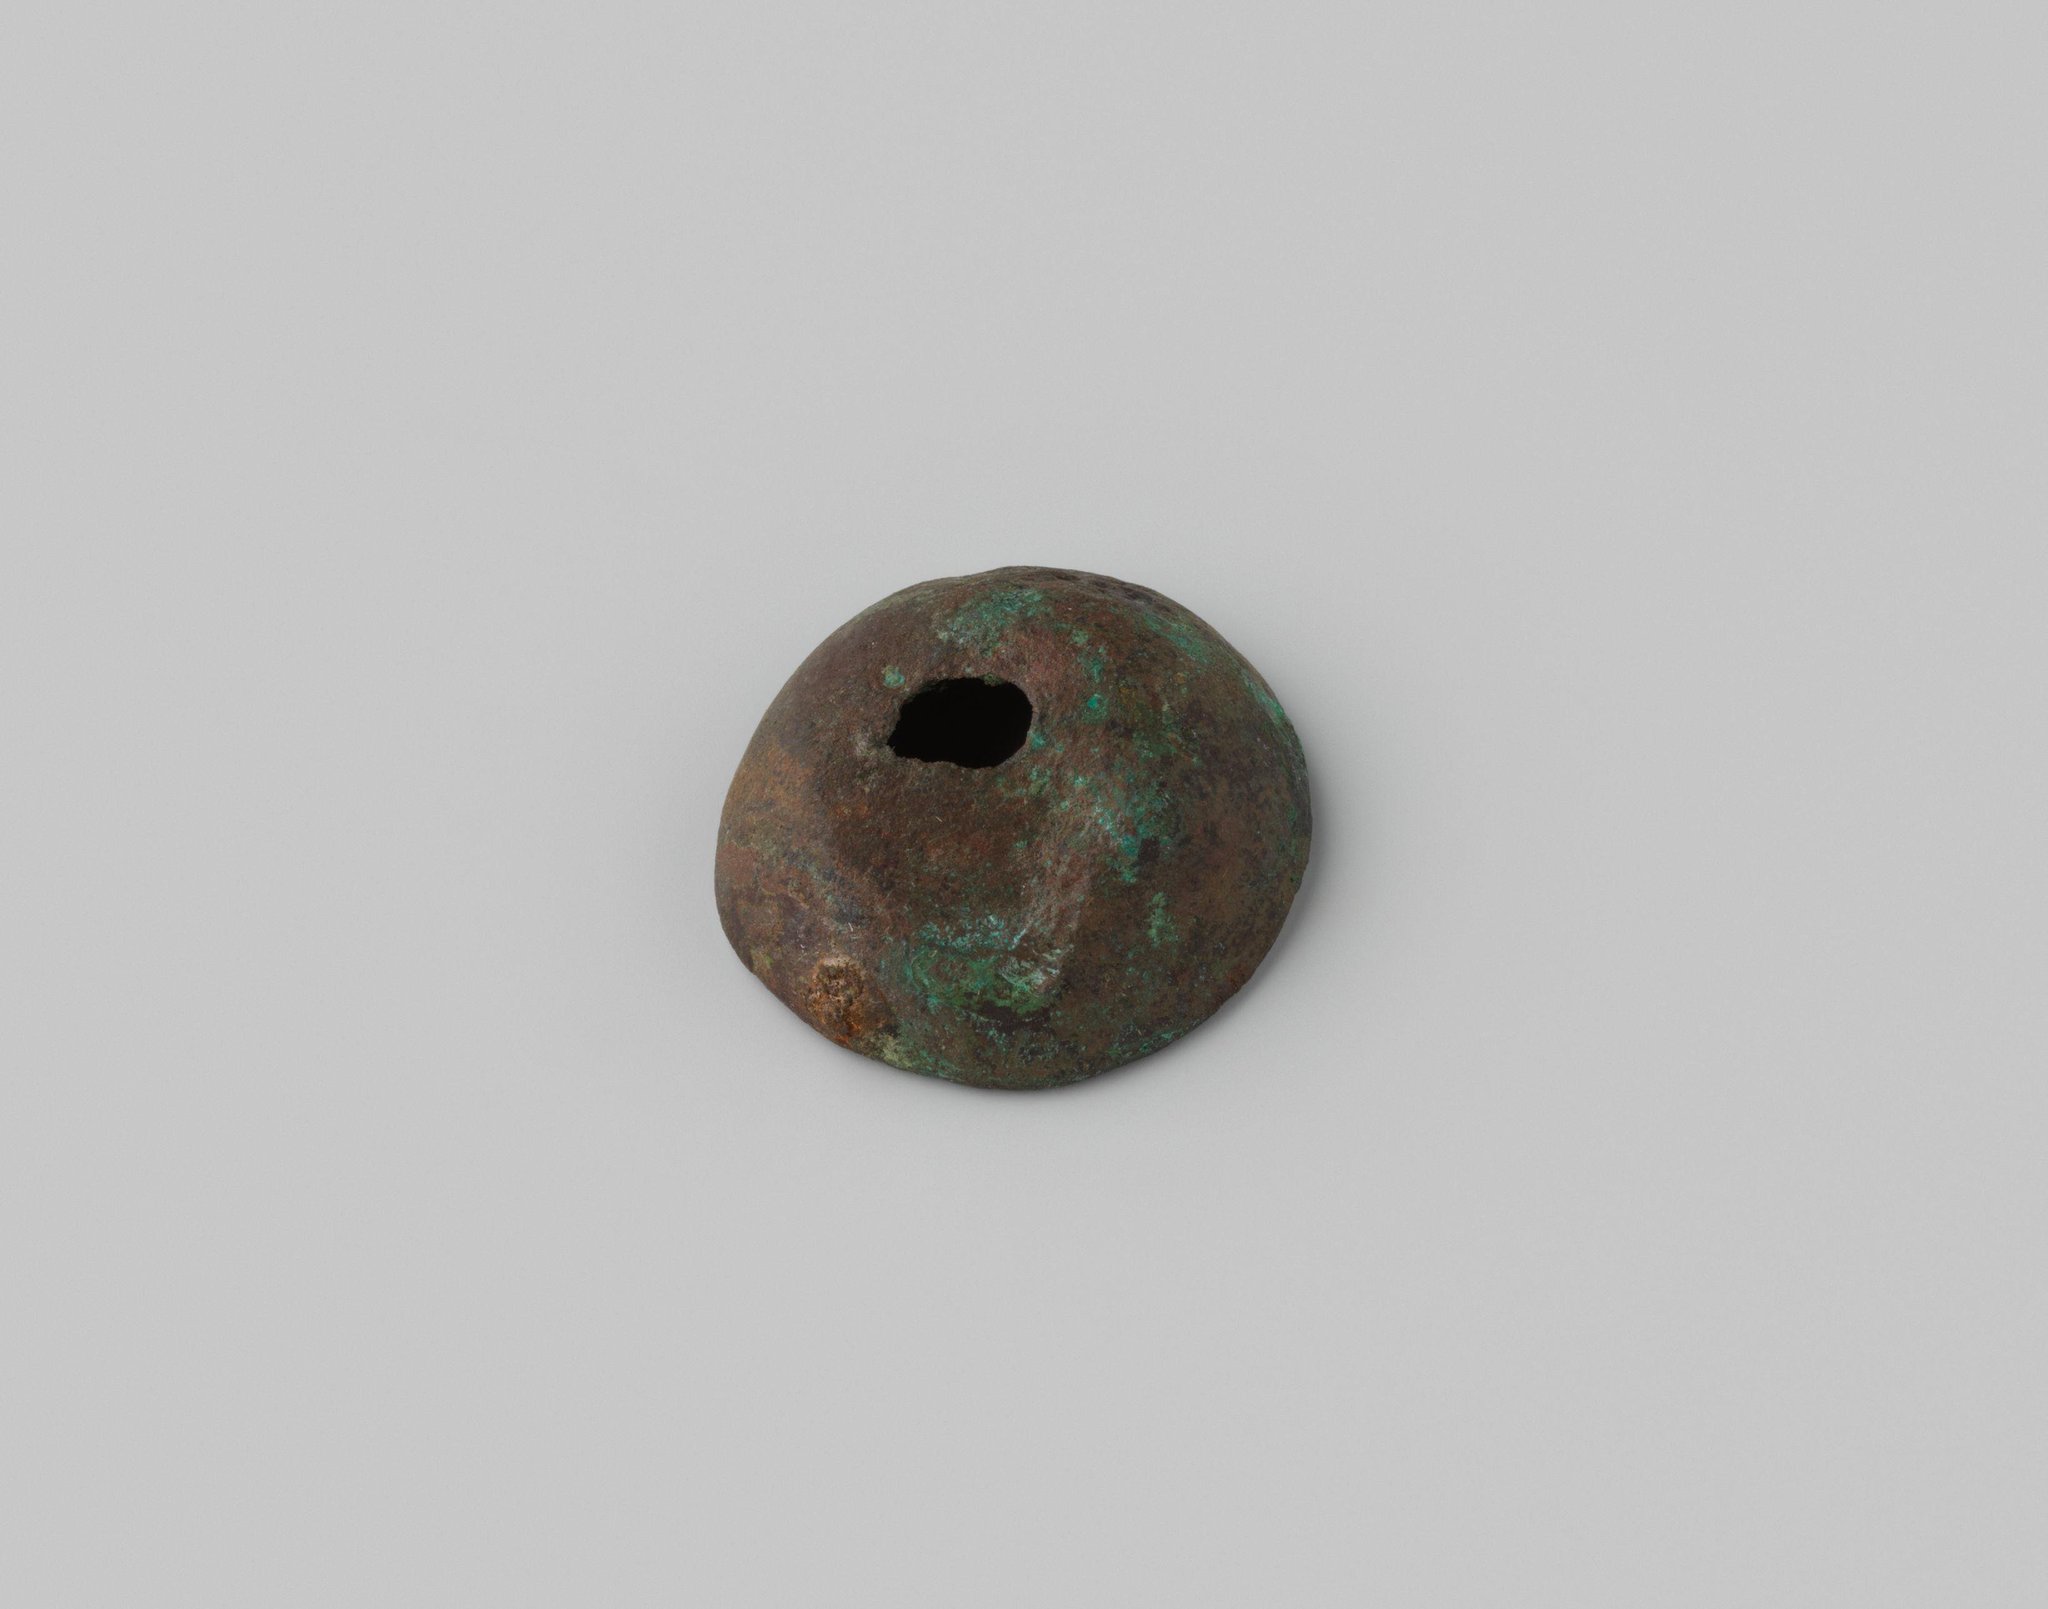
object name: tack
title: Fragment kopspijker afkomstig uit het wrak van de Oost-Indiëvaarder Hollandia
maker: Anonymous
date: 1700-1743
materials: copper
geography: netherlands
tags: verenigde oostindische compagnie, hollandia (schip)